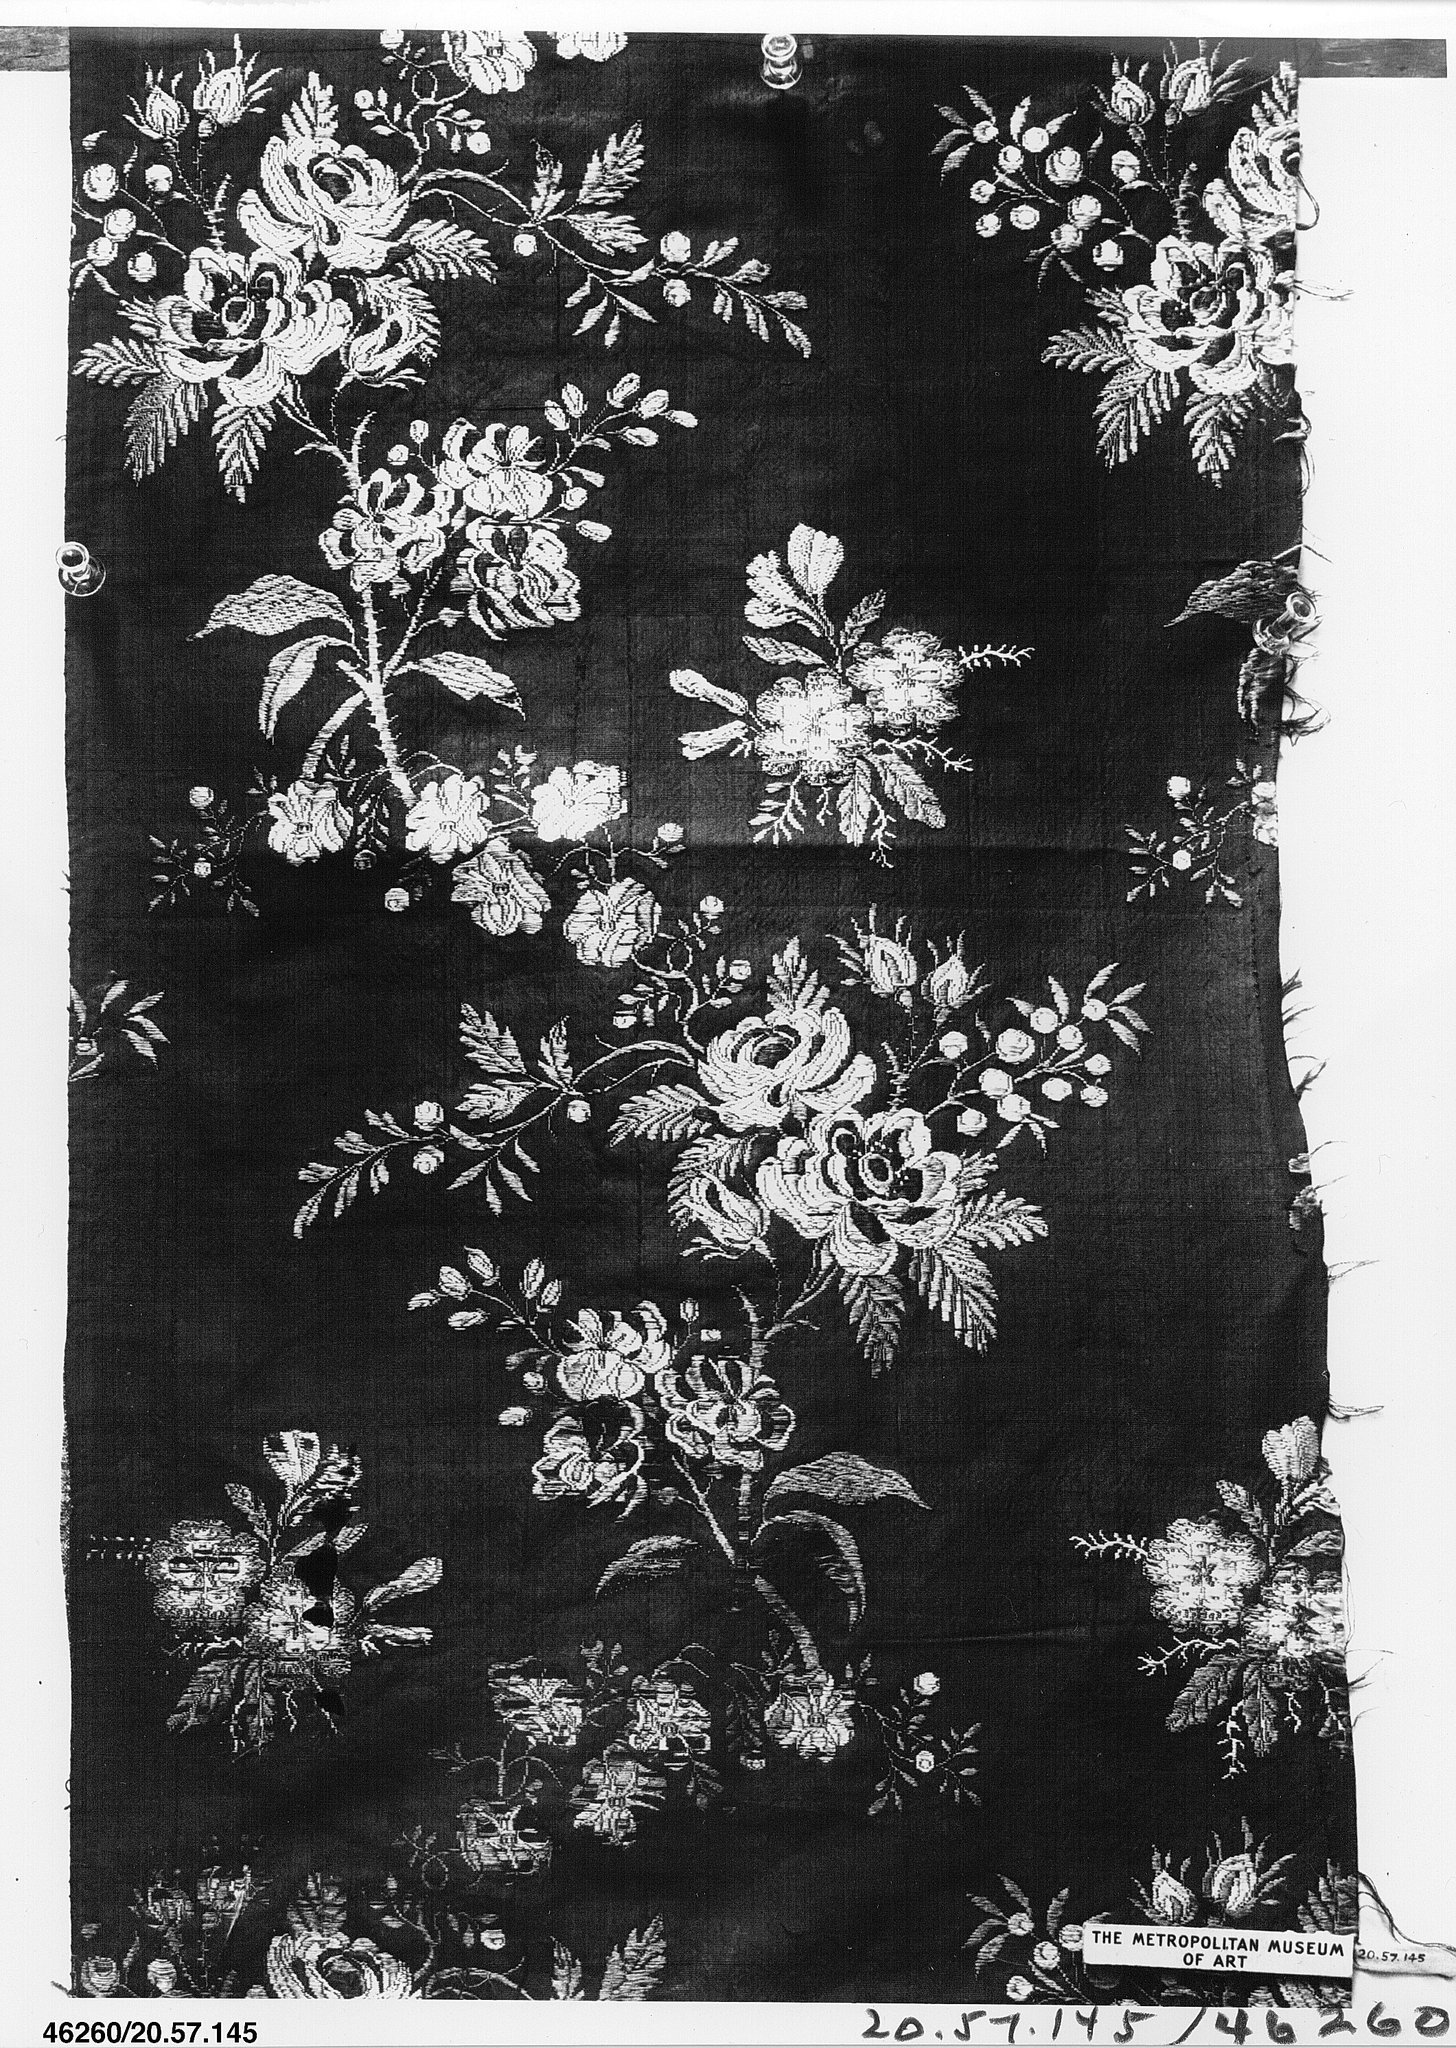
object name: piece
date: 1750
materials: silk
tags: flowers,leaves